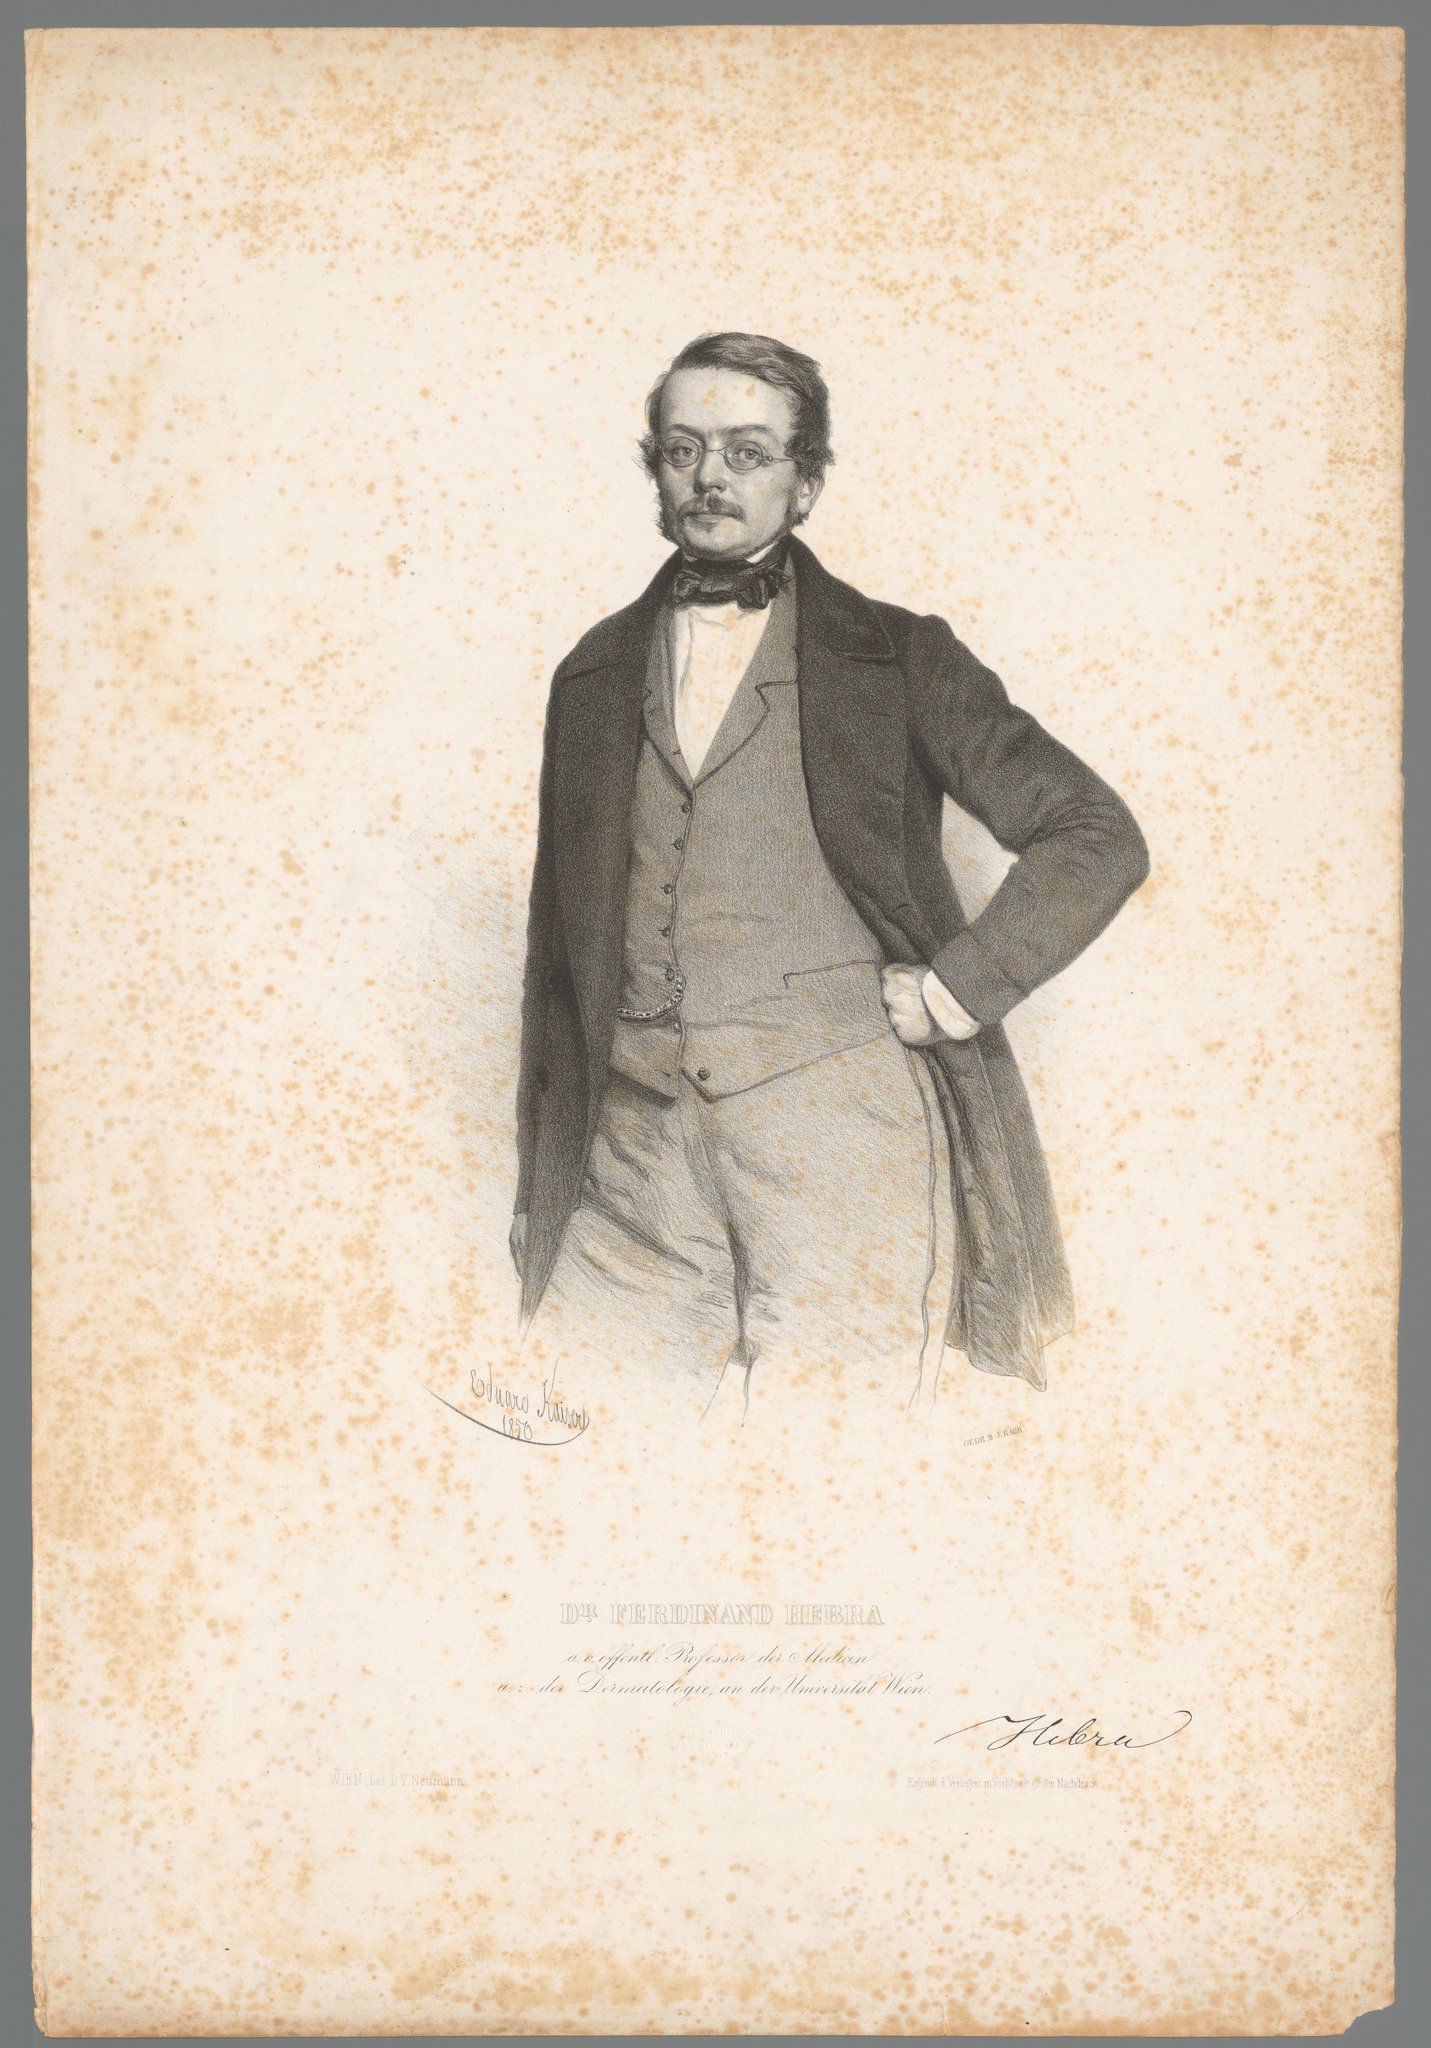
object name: print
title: Dr. Ferdinand Hebra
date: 1850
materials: paper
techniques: lithograph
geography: vienna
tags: eyeglasses, spectacles, moustache, adult man, historical persons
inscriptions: check stamp: ‘Kunsthandlung L.T. Neumann in Wien’, collector's mark: Lugt 2228